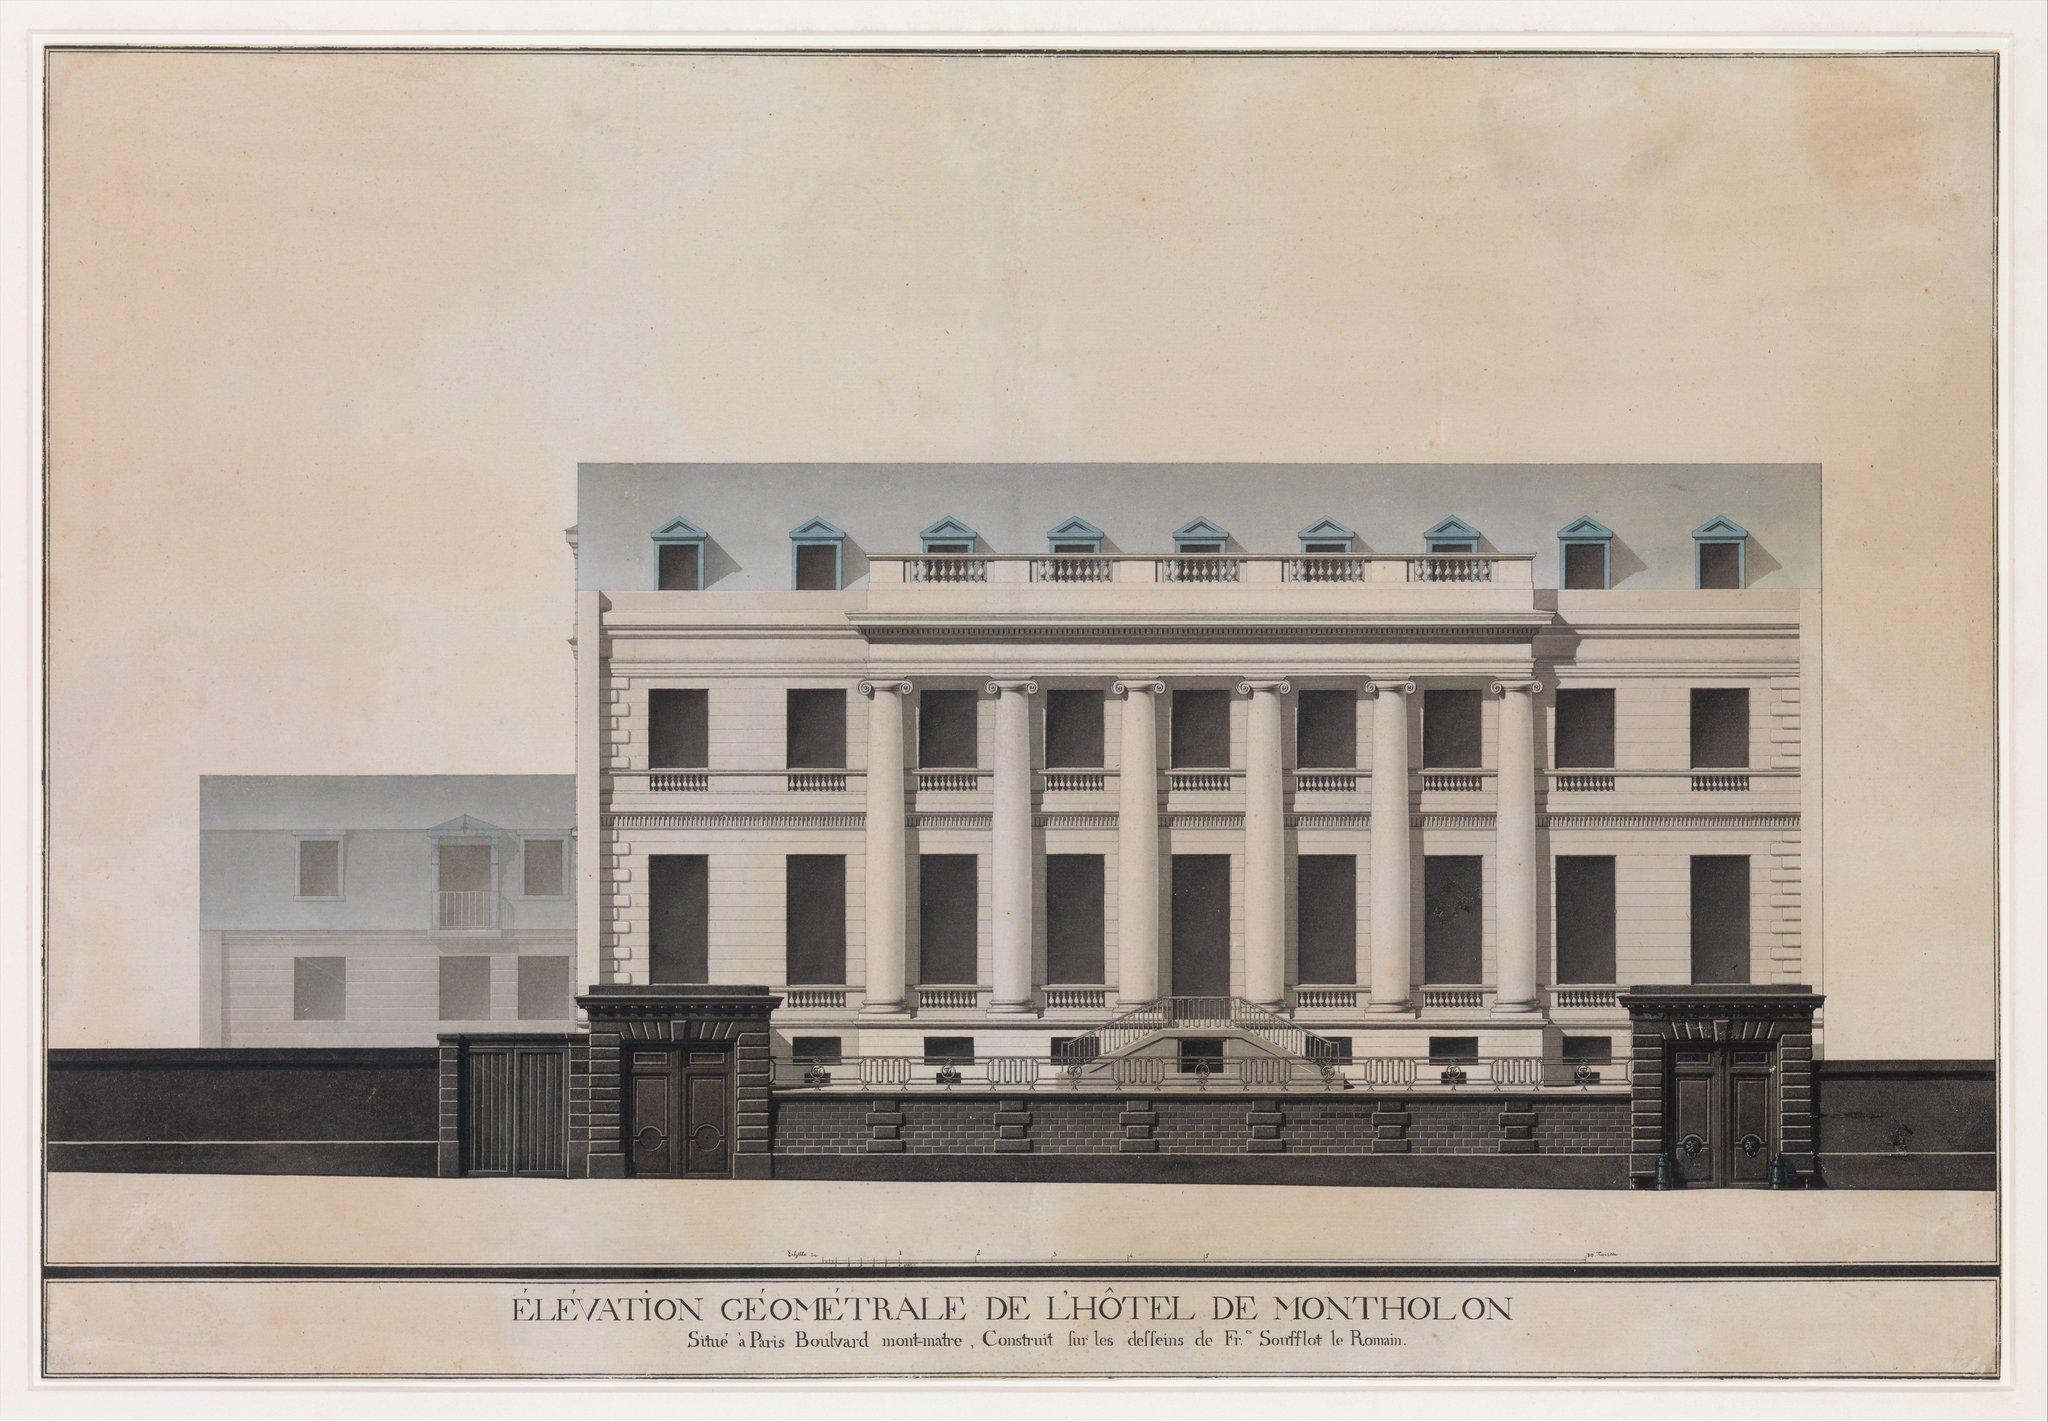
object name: drawing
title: Elevation of the Façade of the Hôtel de Montholon, Paris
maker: jean jacques lequeu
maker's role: artist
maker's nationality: french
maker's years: 1757-1825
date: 1785-1786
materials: ink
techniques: brush, pen, wash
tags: architecture,buildings